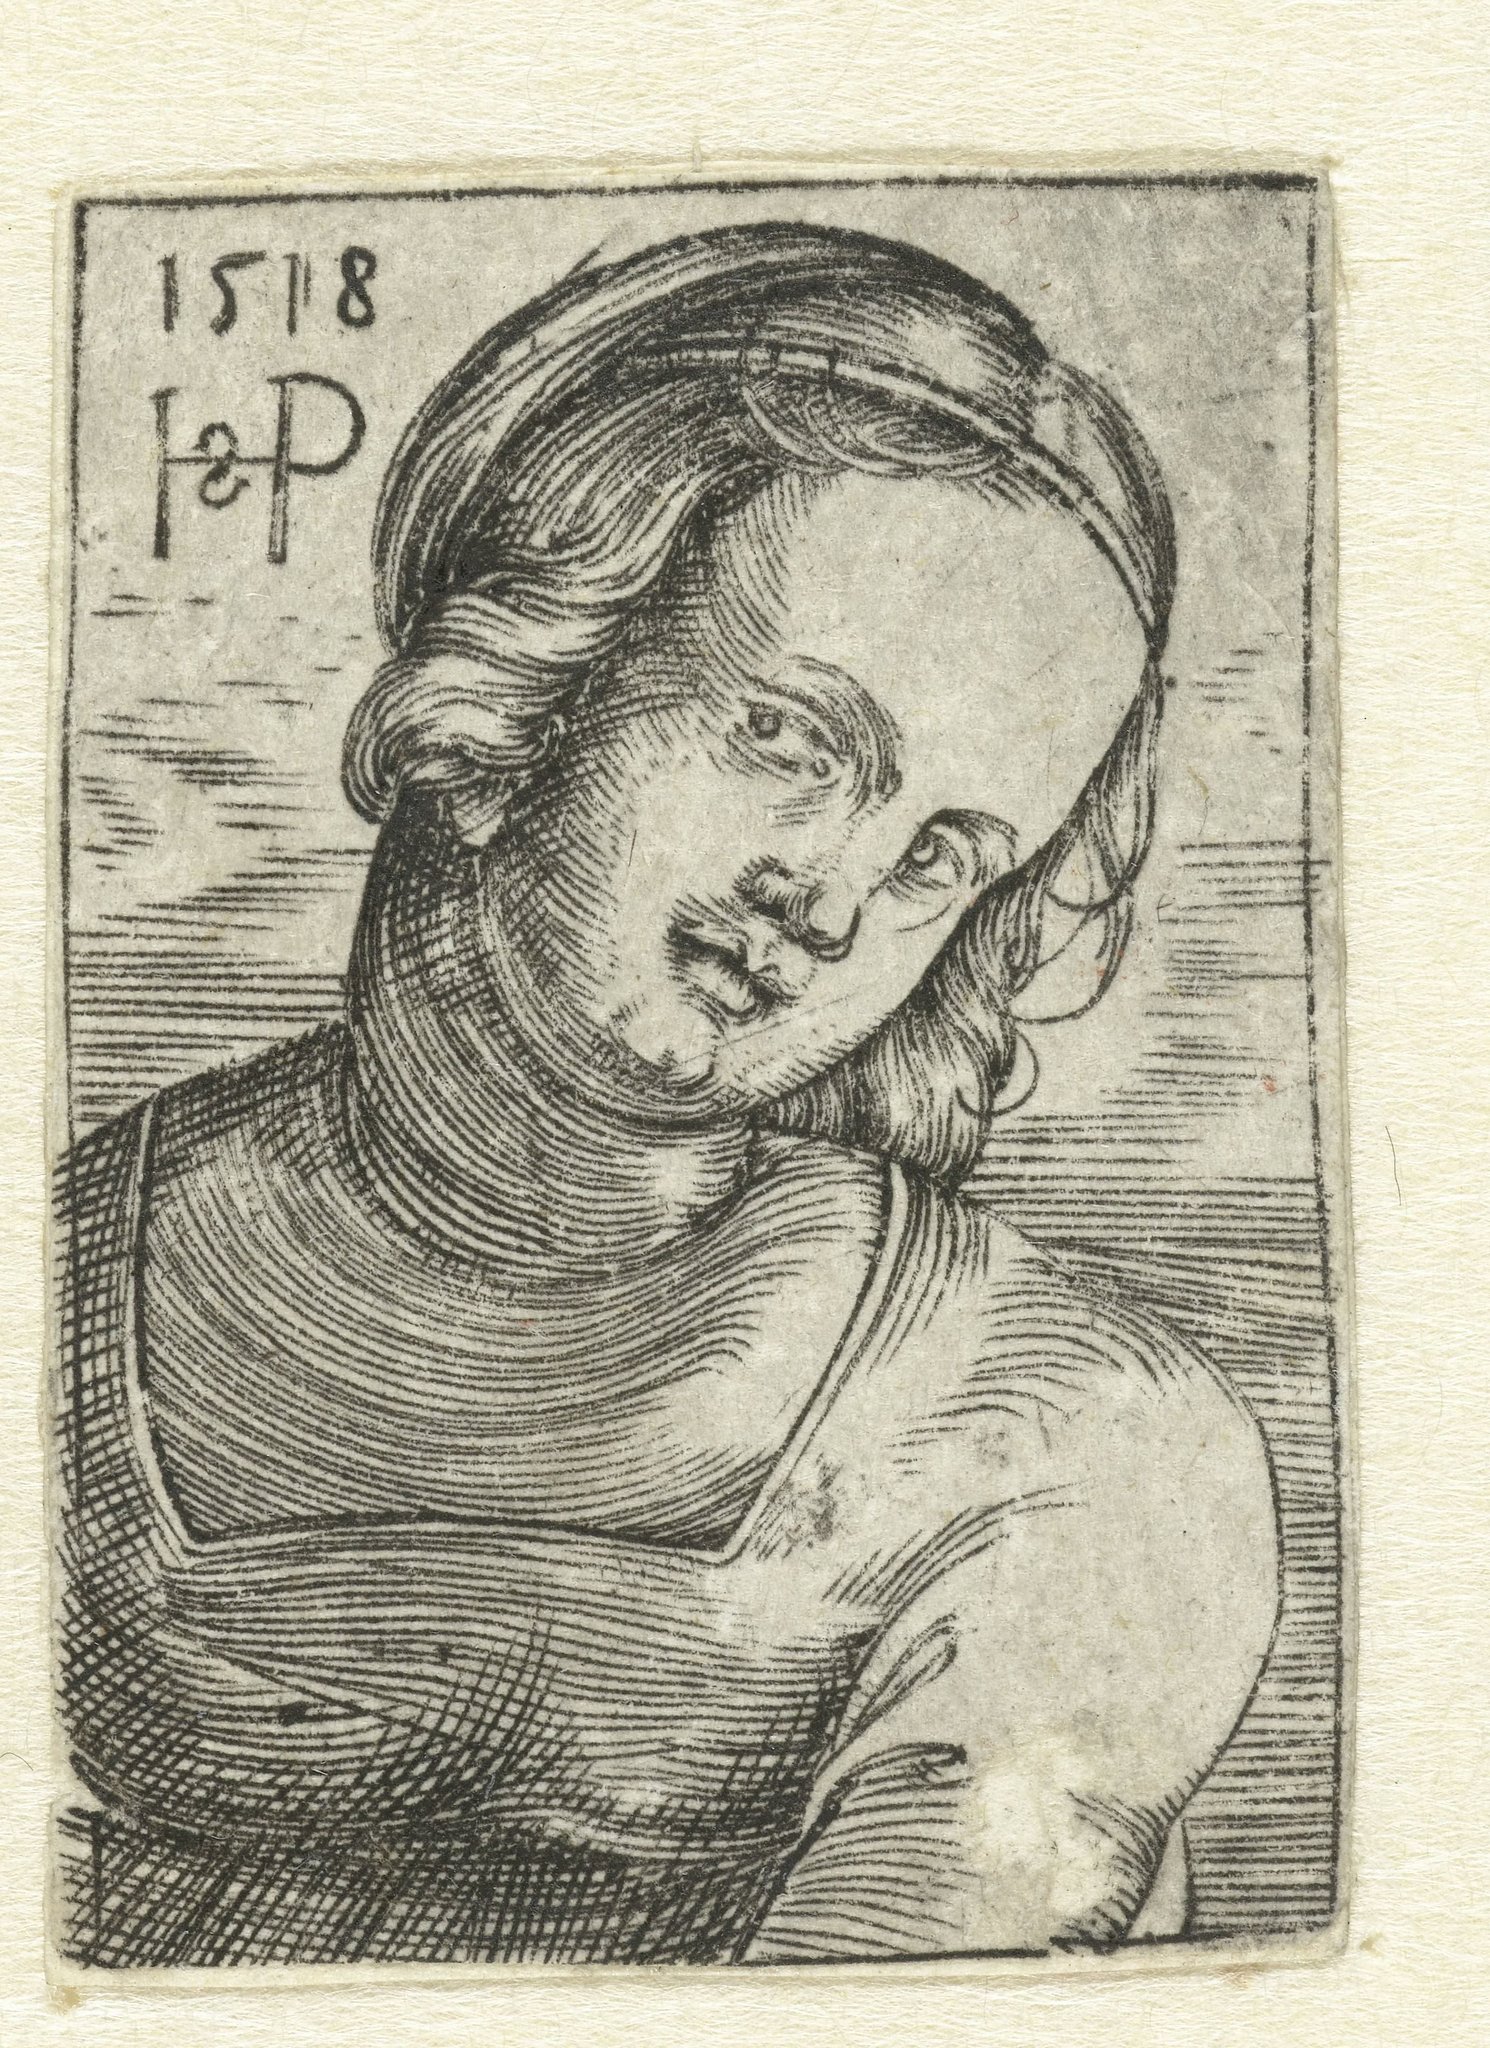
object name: print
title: Borstbeeld van een jonge vrouw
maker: hans sebald beham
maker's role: designer, draughtsman, print maker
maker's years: 1500-1550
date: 1518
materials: paper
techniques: engraving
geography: nuremberg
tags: female sex; woman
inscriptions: collector's mark: Lugt 2228a